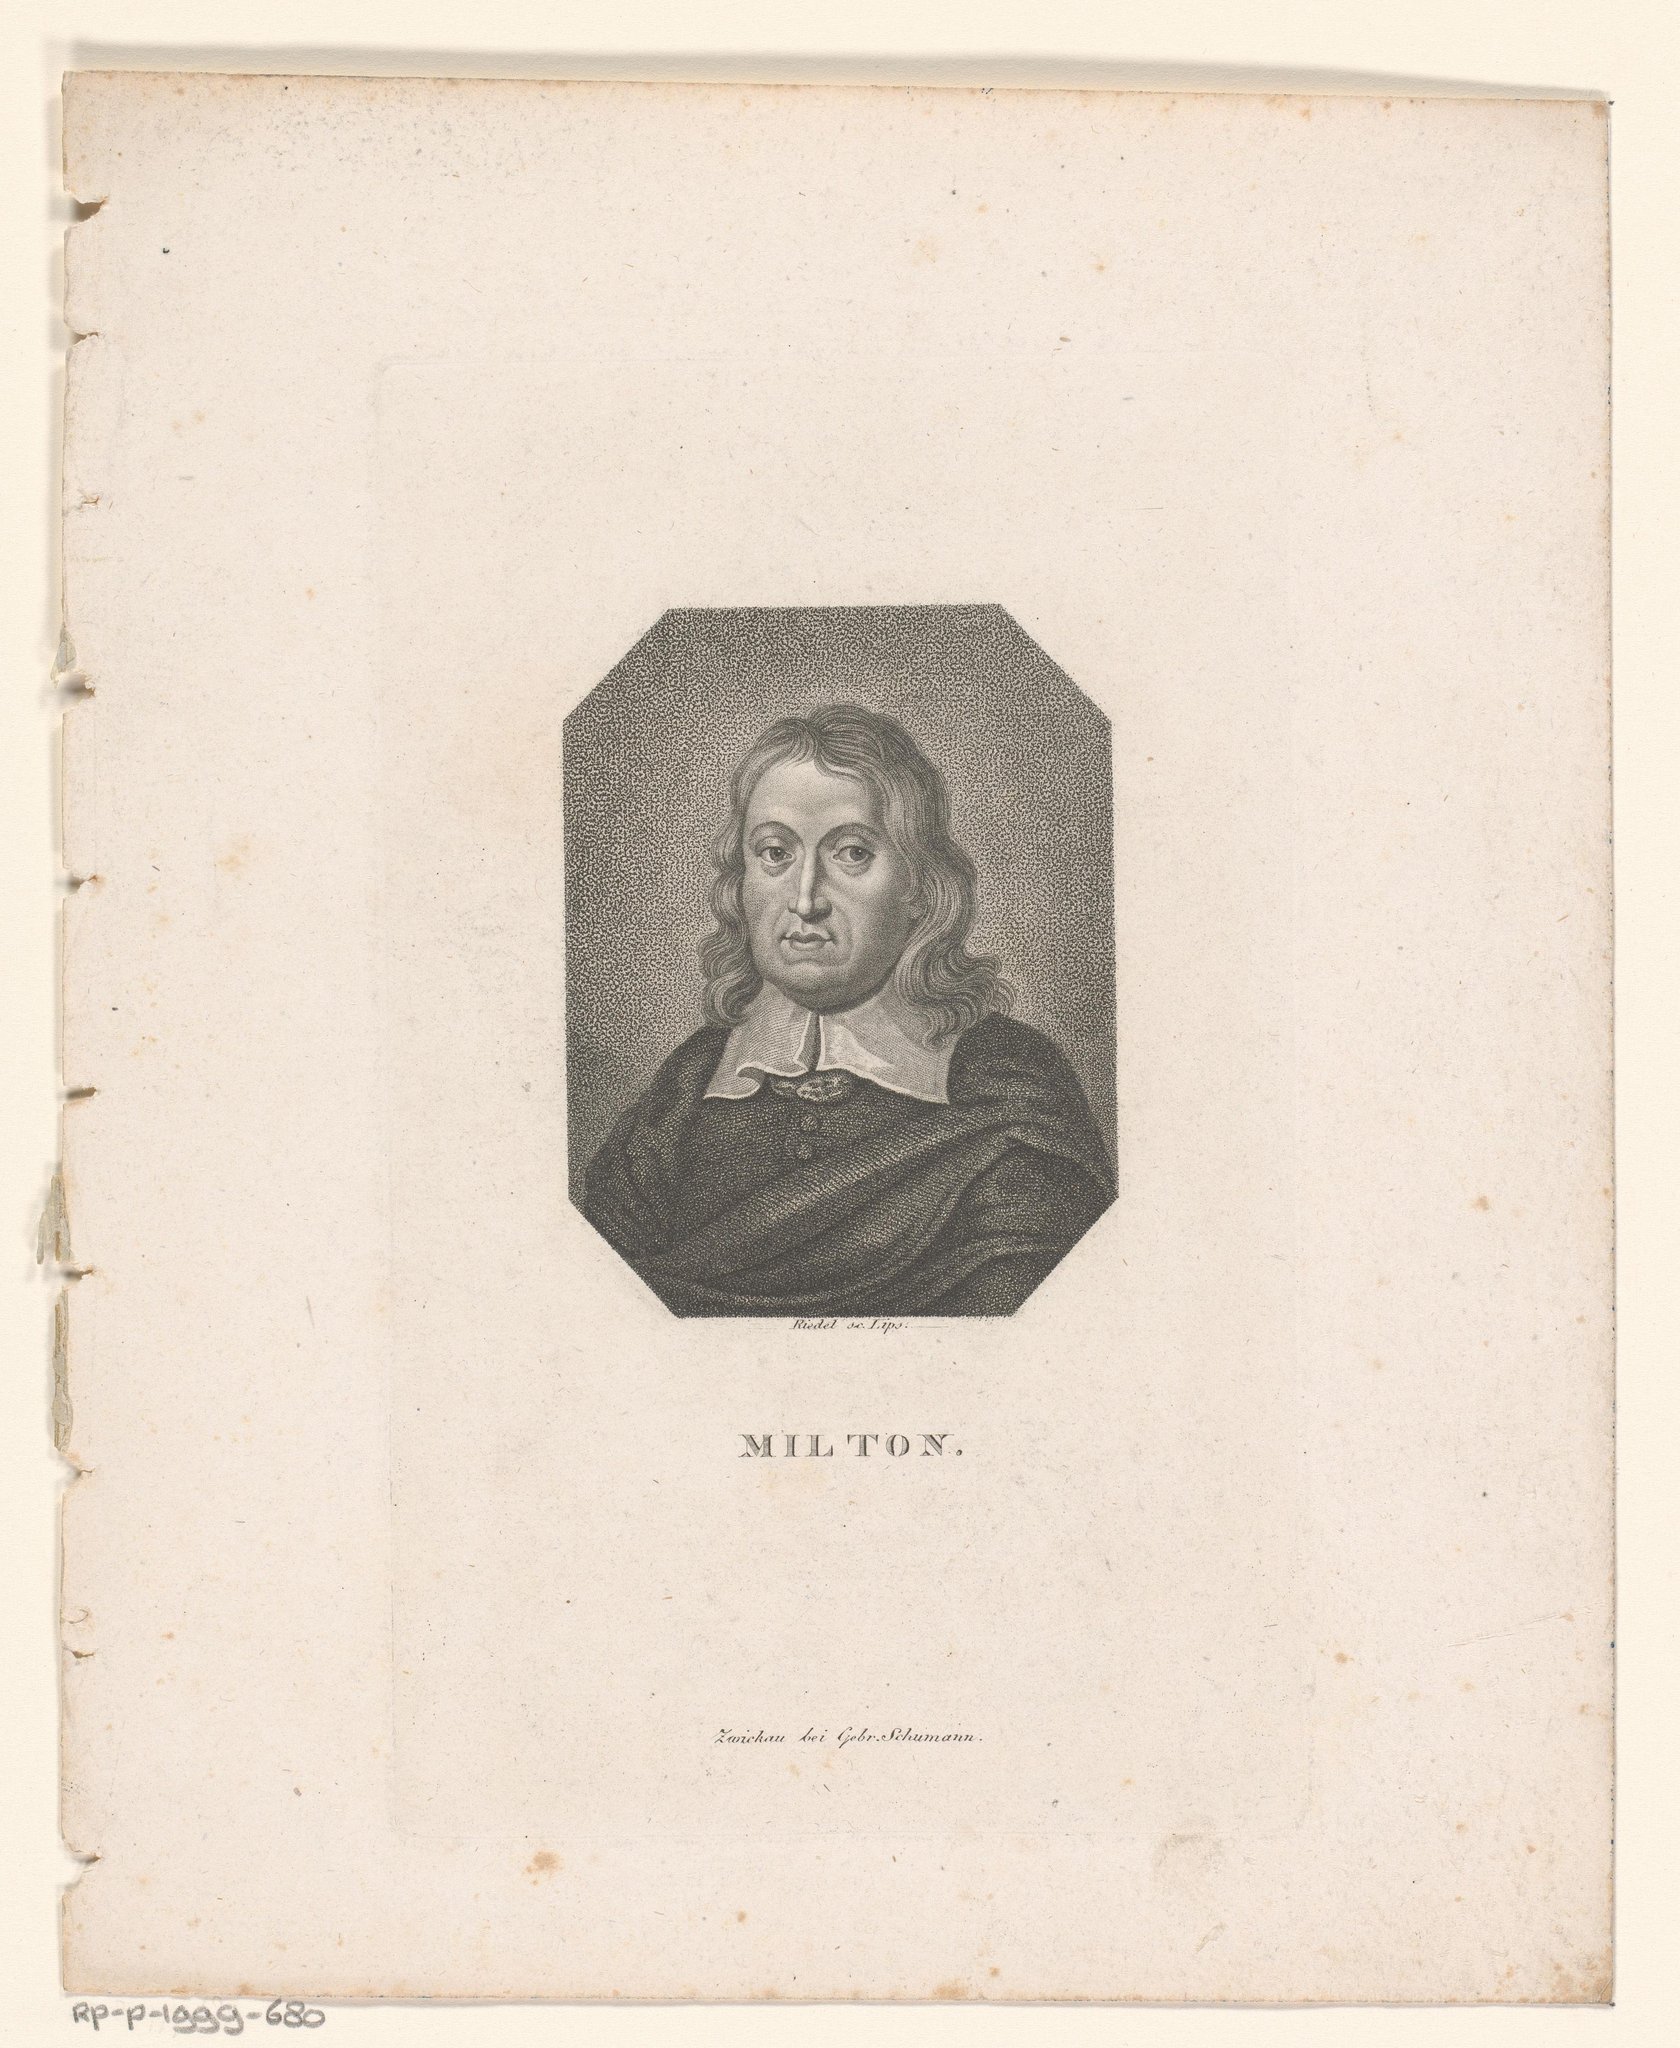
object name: print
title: Portret van John Milton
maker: karl traugott riedel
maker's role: print maker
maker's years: 1769-1832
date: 1818-1832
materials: paper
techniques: engraving, roulette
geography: zwickau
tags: london, john milton, historical persons, portrait of a writer, writer, poet, author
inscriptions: collector's mark: Lugt 2760, collector's mark: Lugt 2228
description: Prent waarschijnlijk uit: Bildnisse der berühmtesten Menschen aller Völker und Zeiten. S.l.: Zwickau en Leipzig: Schumann, 1818-1832.